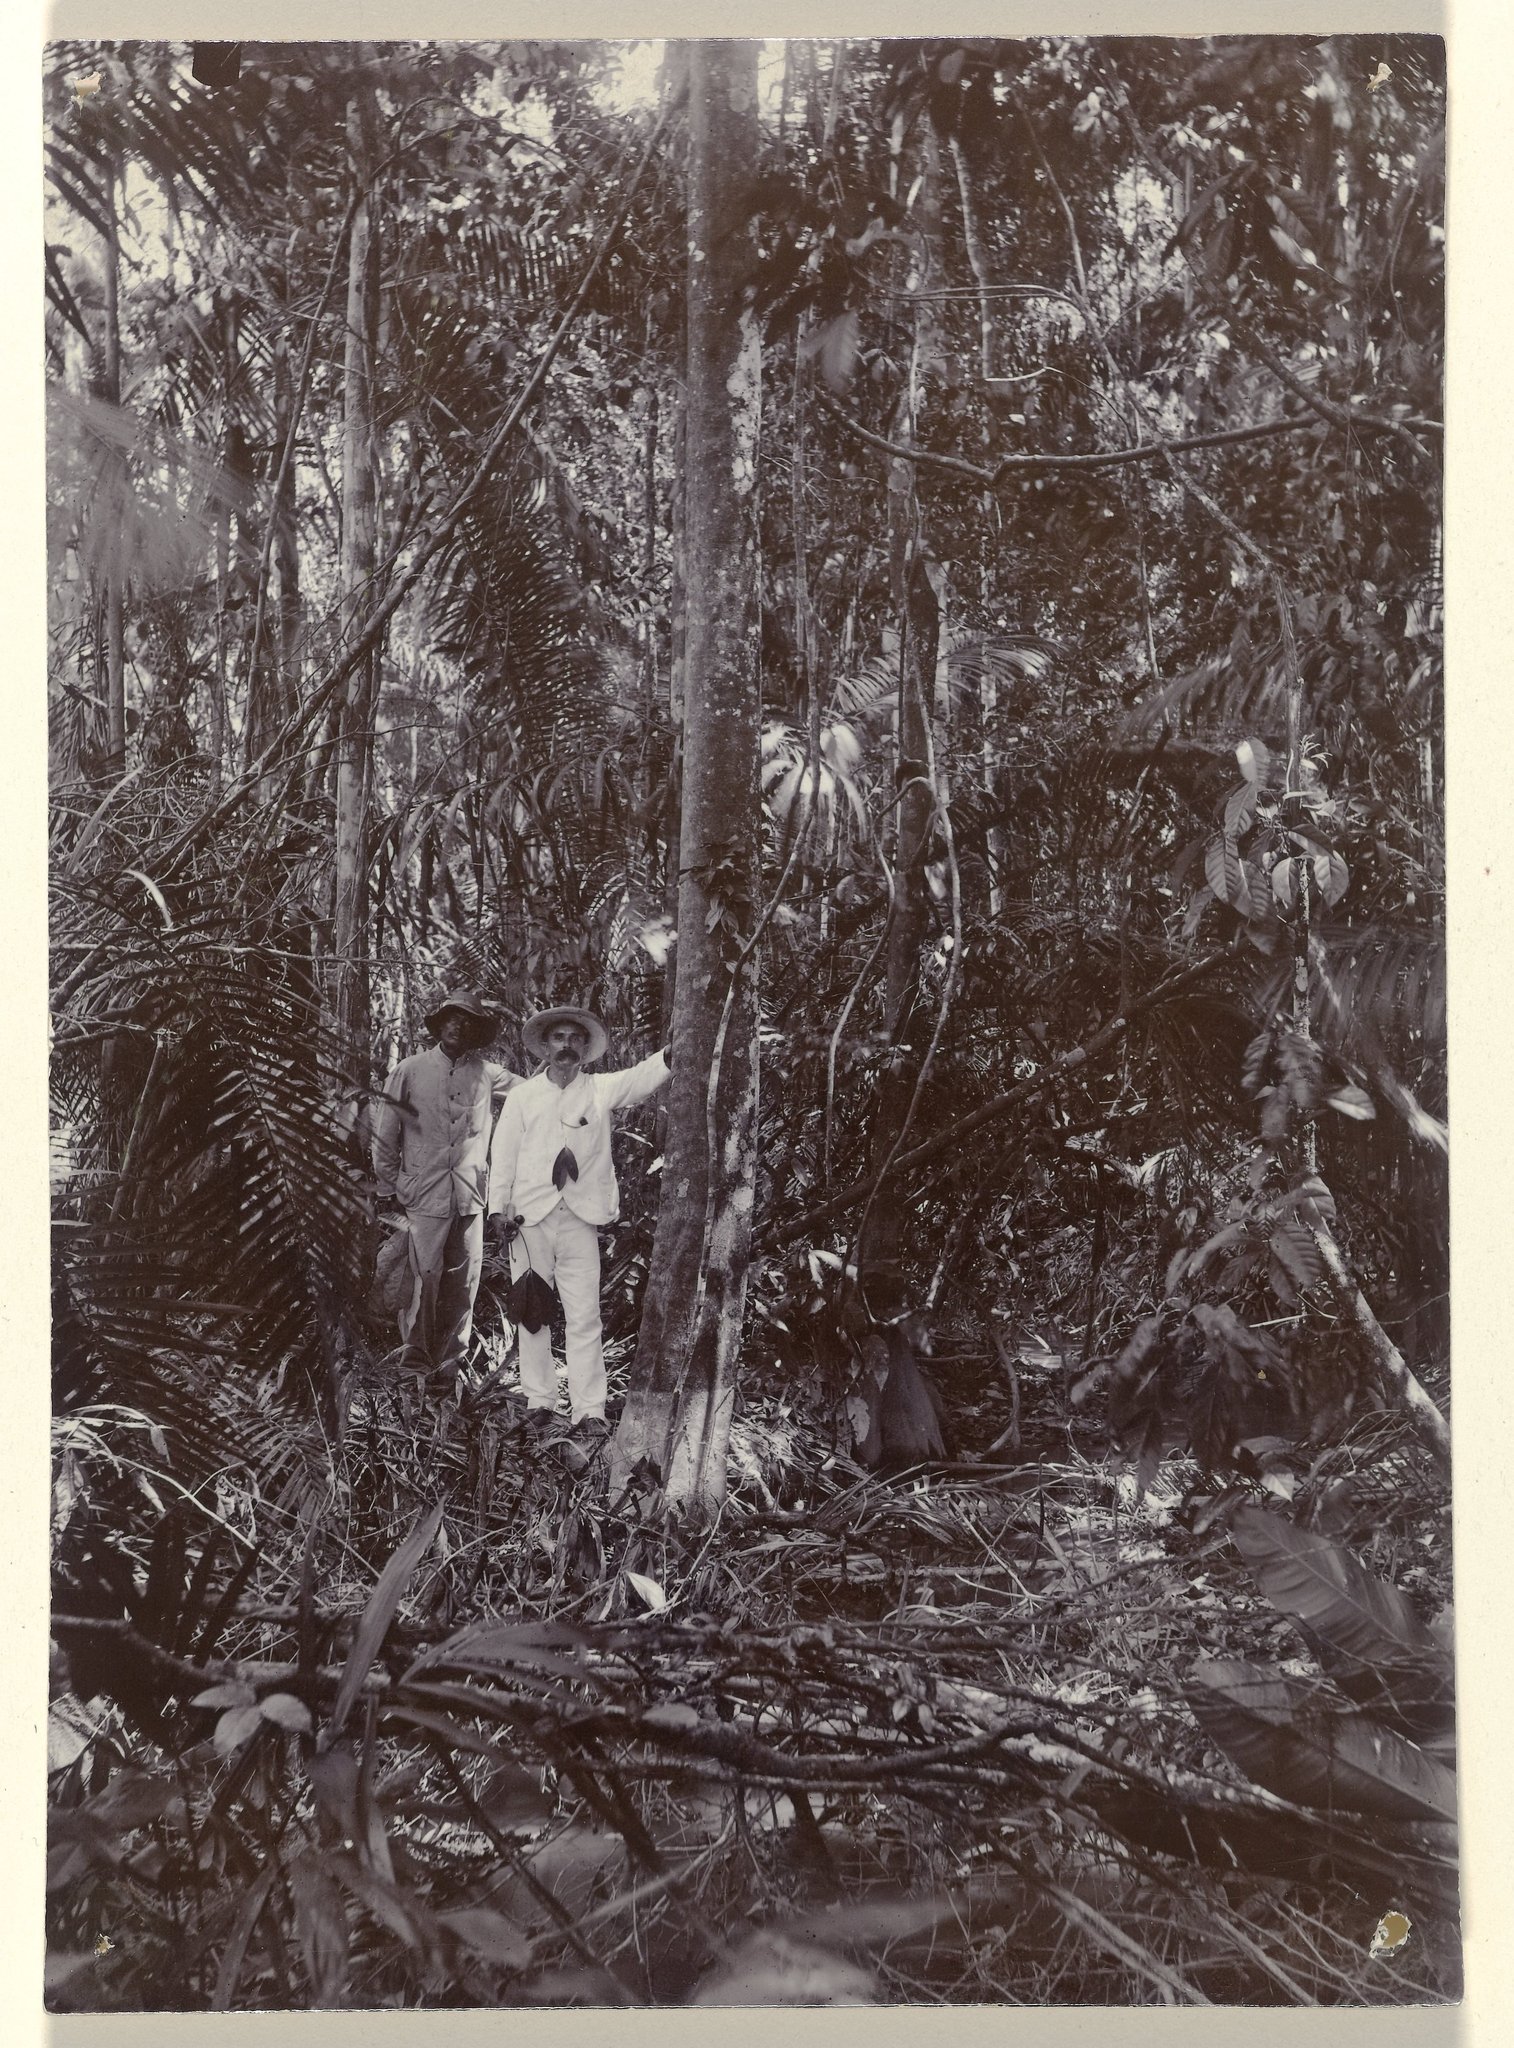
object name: photograph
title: De heer Gonggrijp, werknemer van de Lawaspoorlijn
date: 1905-1910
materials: photographic support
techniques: photography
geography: suriname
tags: railway, train, suriname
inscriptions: annotation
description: De heer Gonggrijp staande in het oerwoud bij een Heveaboom (rubberboom). Onderdeel van een groep objecten afkomstig van de familie Wesenhagen in Suriname. Zie ook de foto in het fotoalbum over de aanleg van de Lawaspoorweg in Suriname in de jaren 1903-1912.